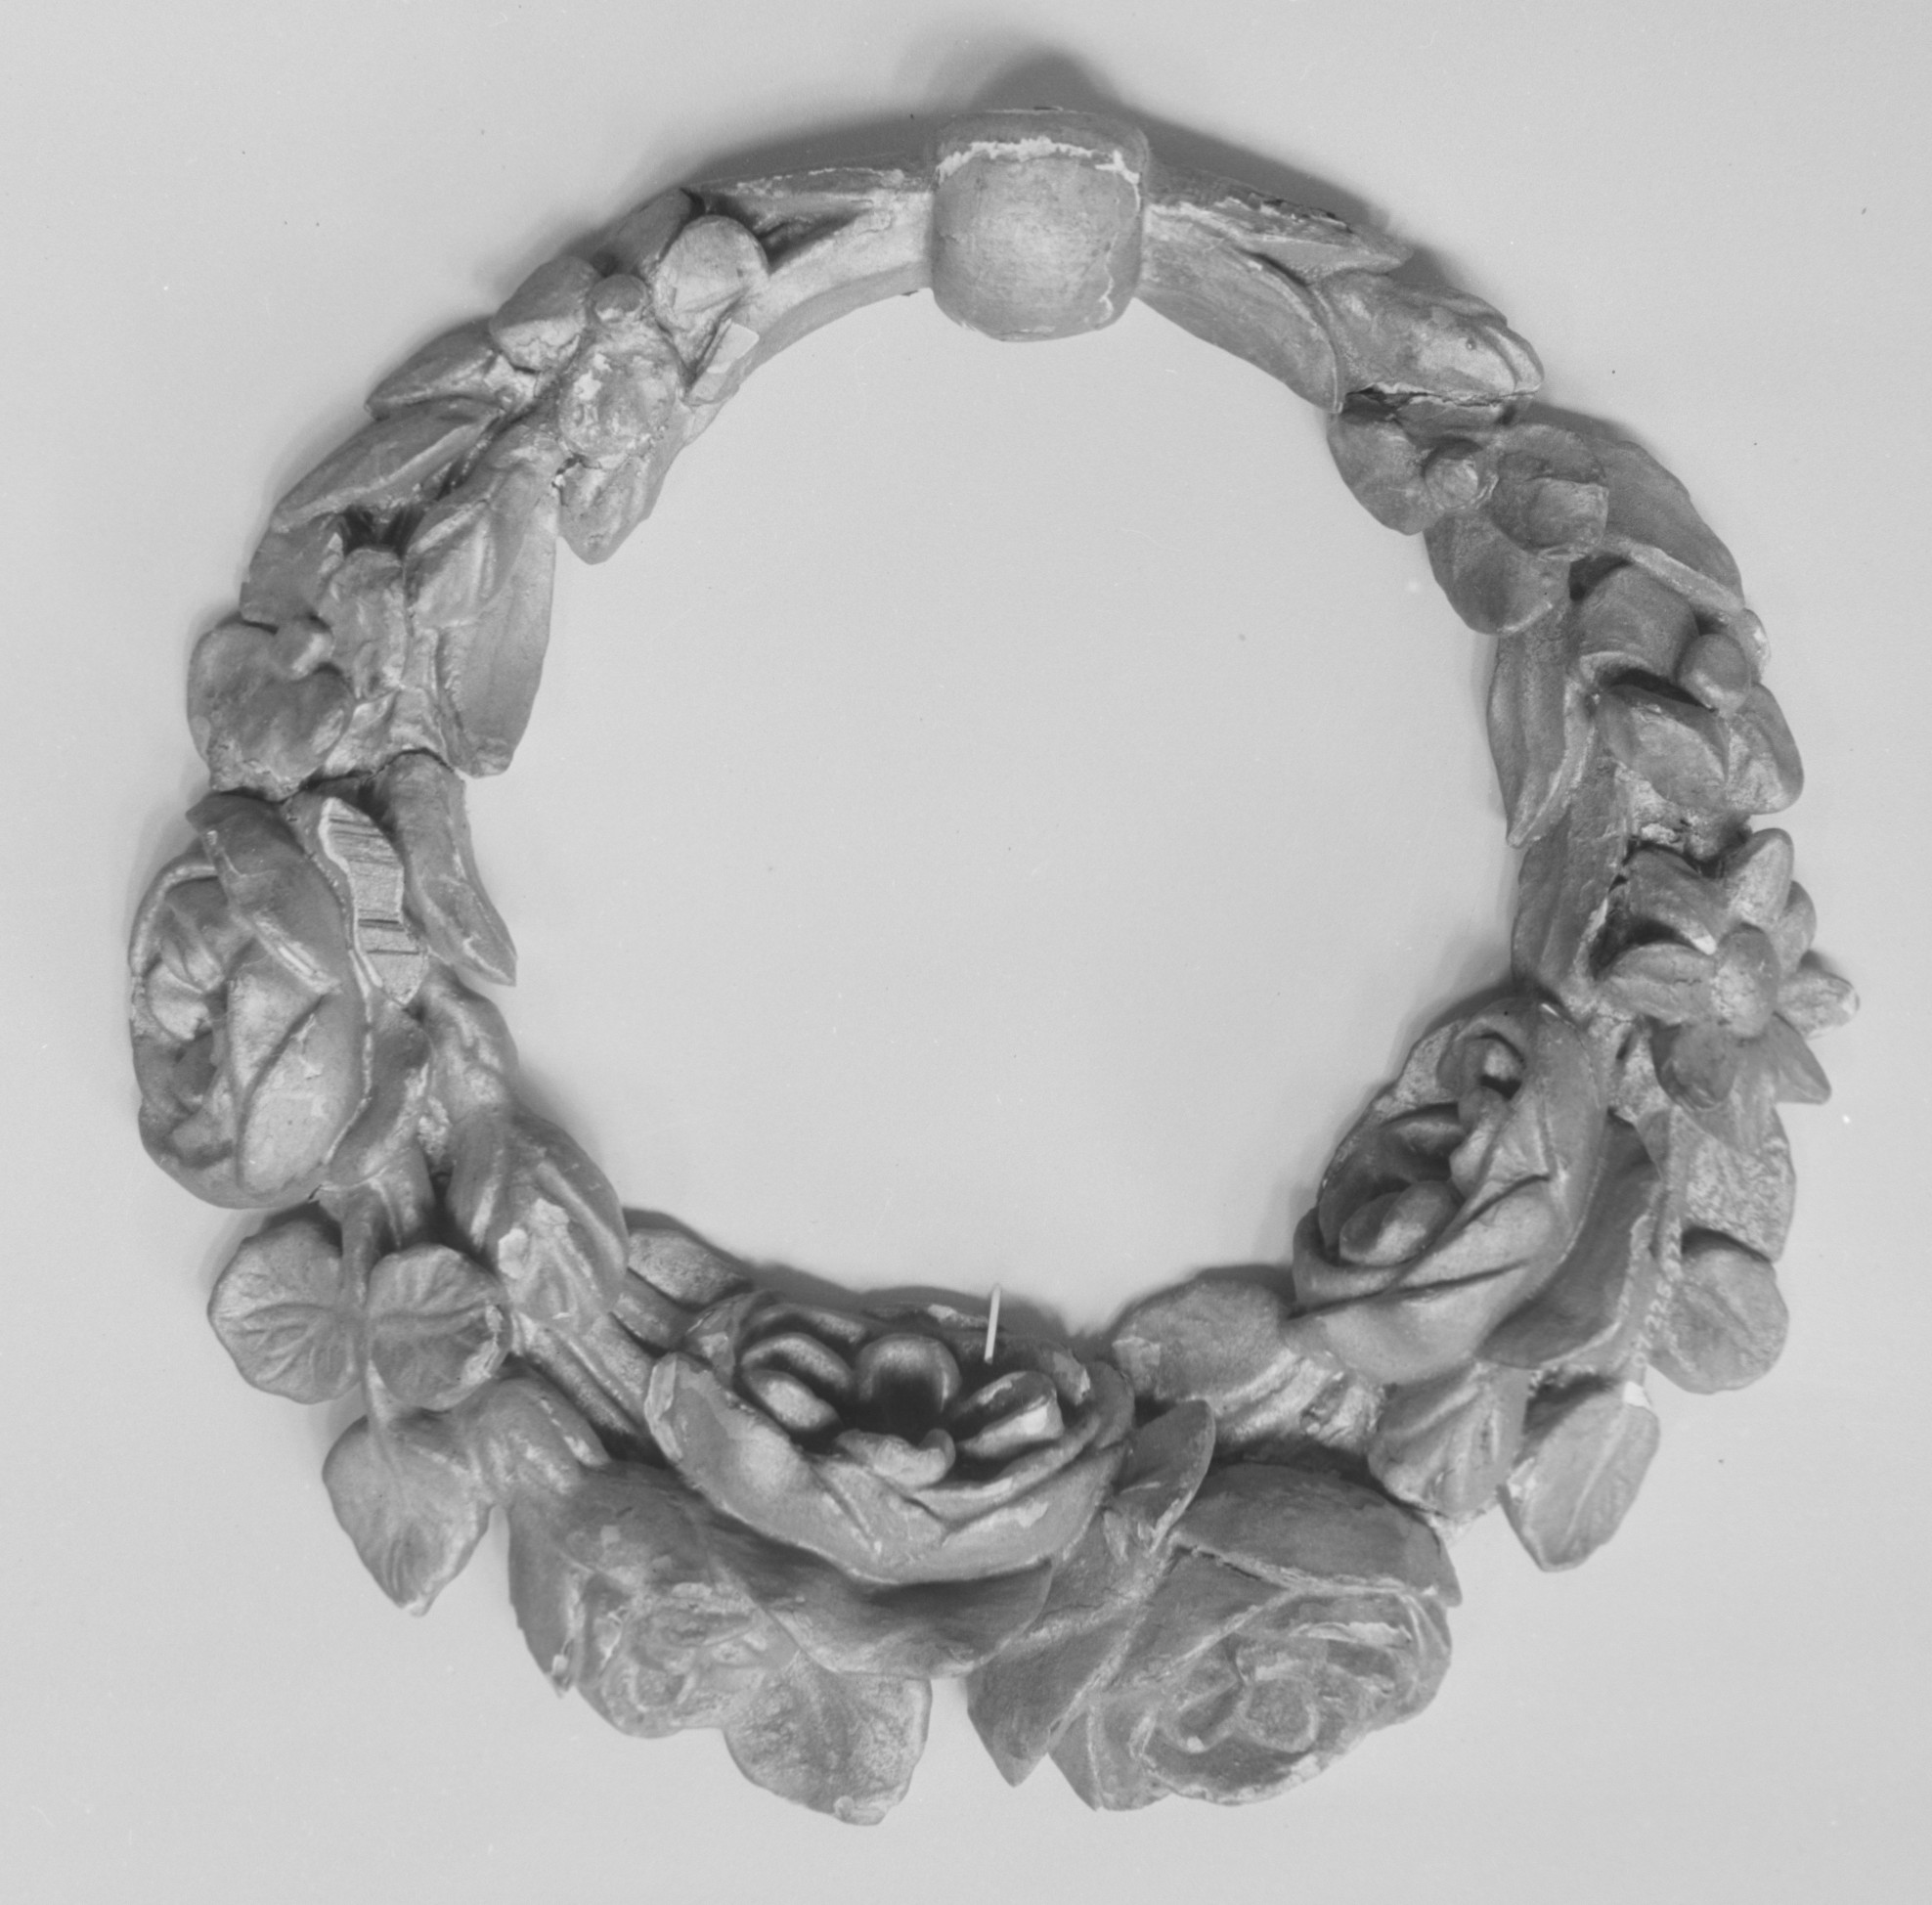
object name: wreath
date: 1701-1800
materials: gilt, wood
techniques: carving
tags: flowers,leaves,wreaths